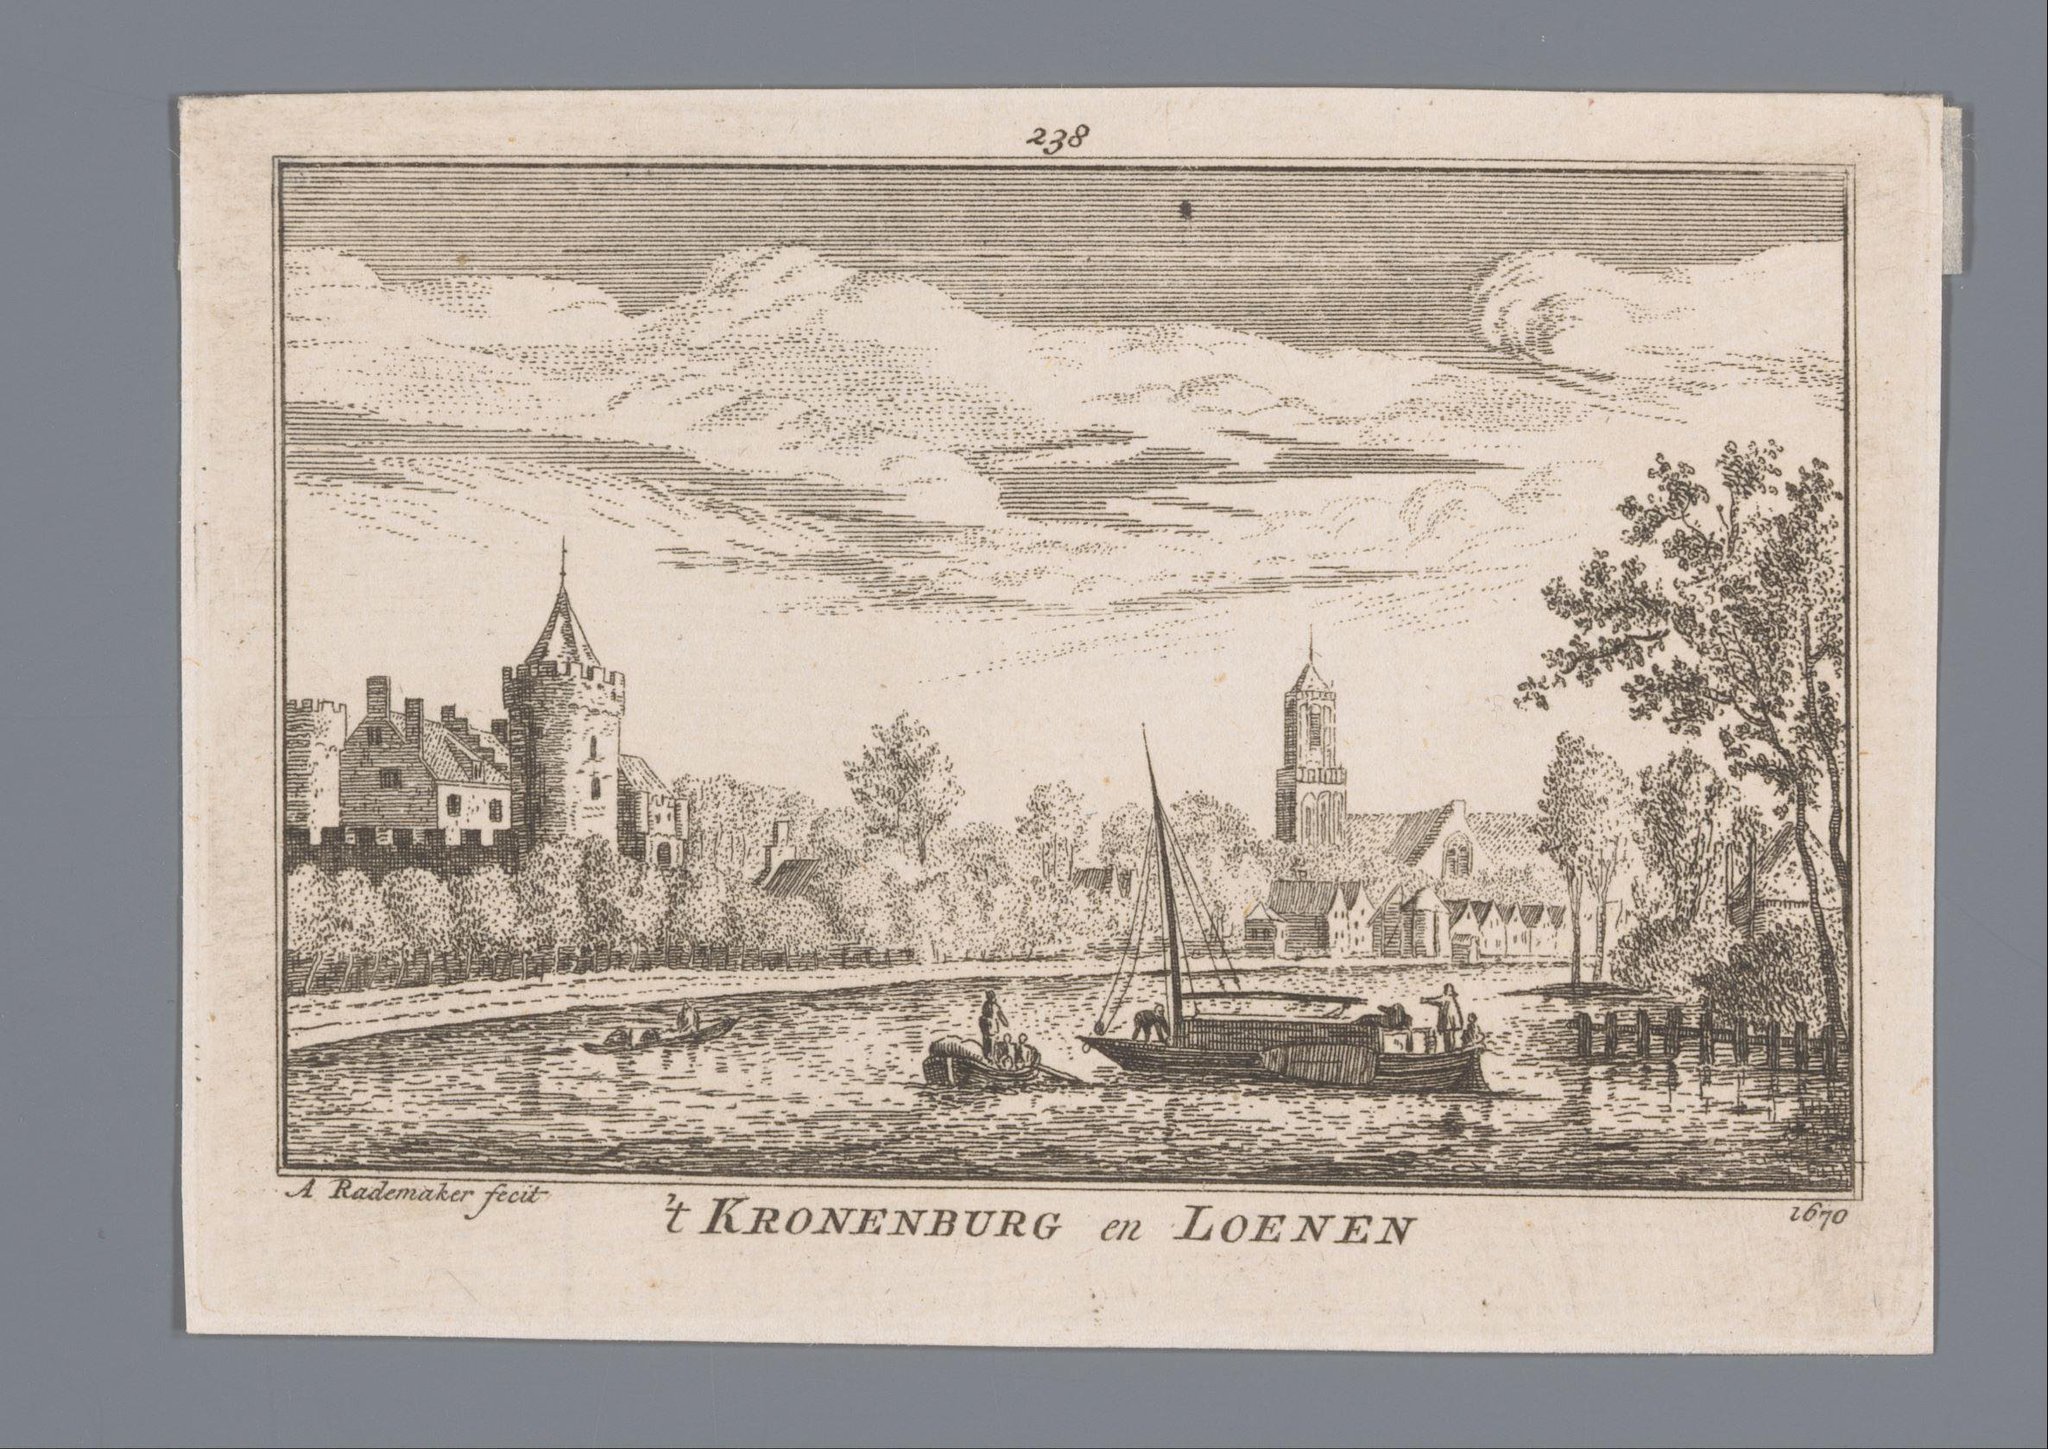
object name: print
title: 't Kronenburg en Loenen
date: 1727-1733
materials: paper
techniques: etching, letterpress printing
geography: amsterdam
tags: castle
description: Prent uit: Rademaker, Abraham, en Matthaeus Brouërius van Niedek, en Isaac Le Long. Kabinet van Nederlandsche en Kleefsche outheden en (...) voorname stads- en landgebouwen. Amsterdam: Willem Barents en Antoni Schoonenburg, 1727-1733, ill. 238.